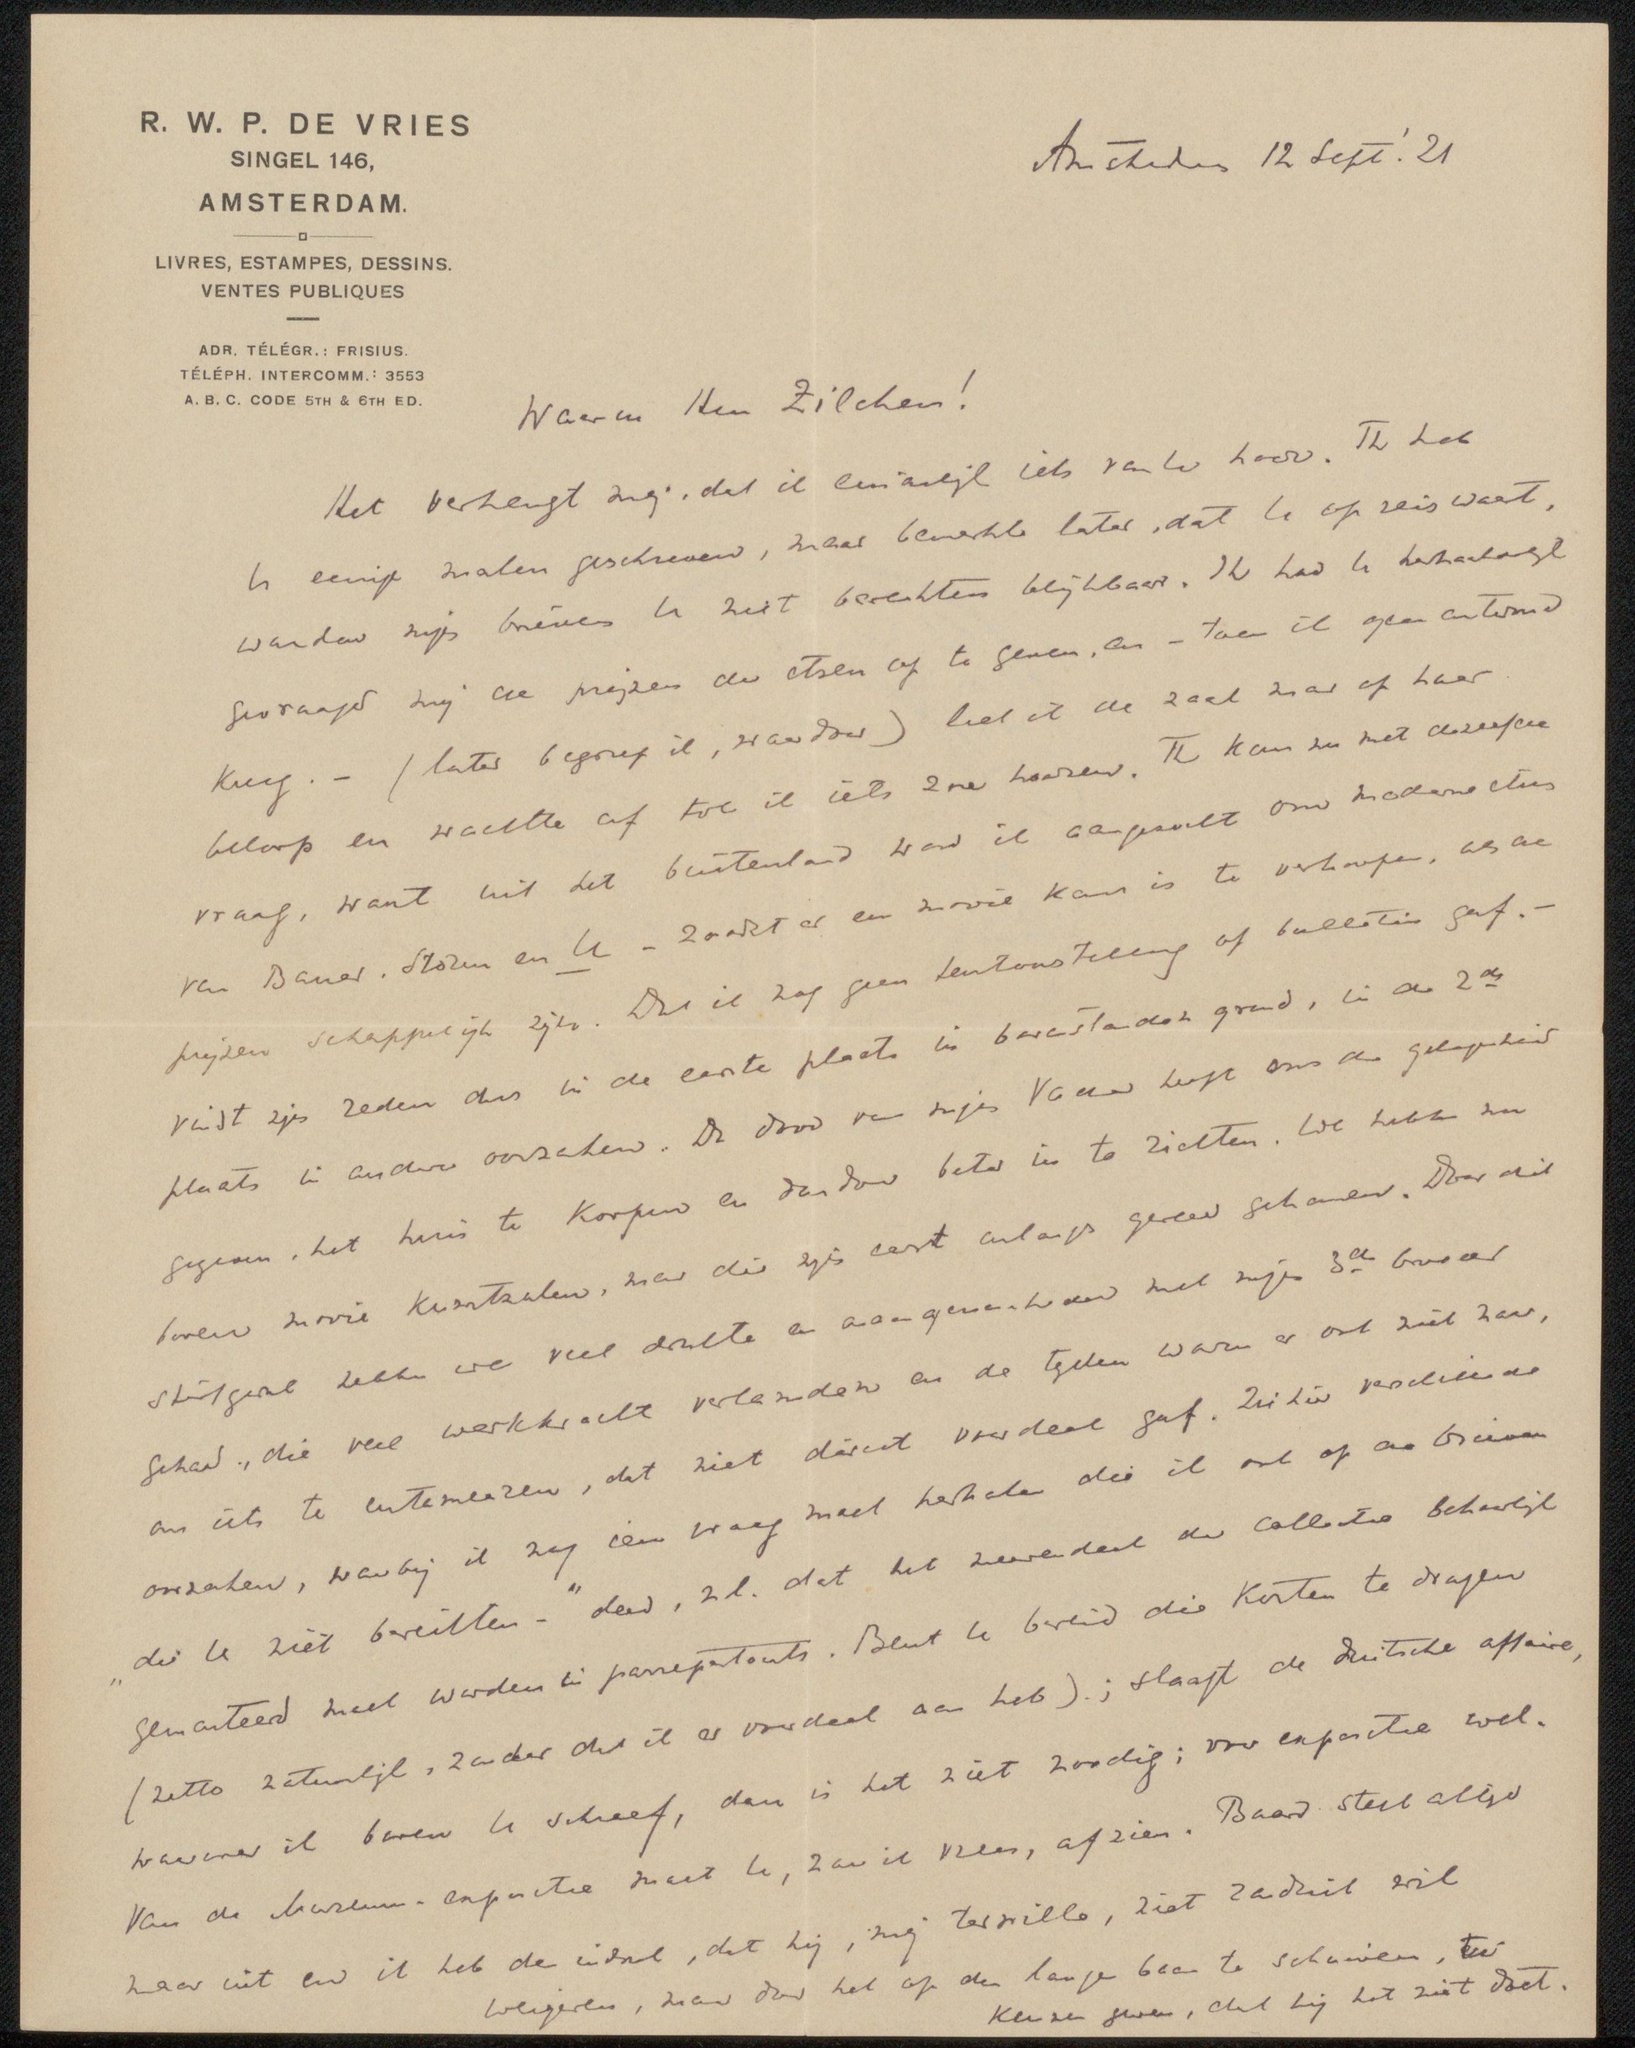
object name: letter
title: Brief aan Philip Zilcken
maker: Anonymous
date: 1921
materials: ink, paper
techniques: pen, printing, writing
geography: amsterdam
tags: carel nicolaas storm van 's-gravesande, the hague, amsterdam, print maker, draughtsman, marius bauer, painter, philip zilcken, art trade, art shop, the graphic arts, money, printed matter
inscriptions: collector's mark: ‘RPK’